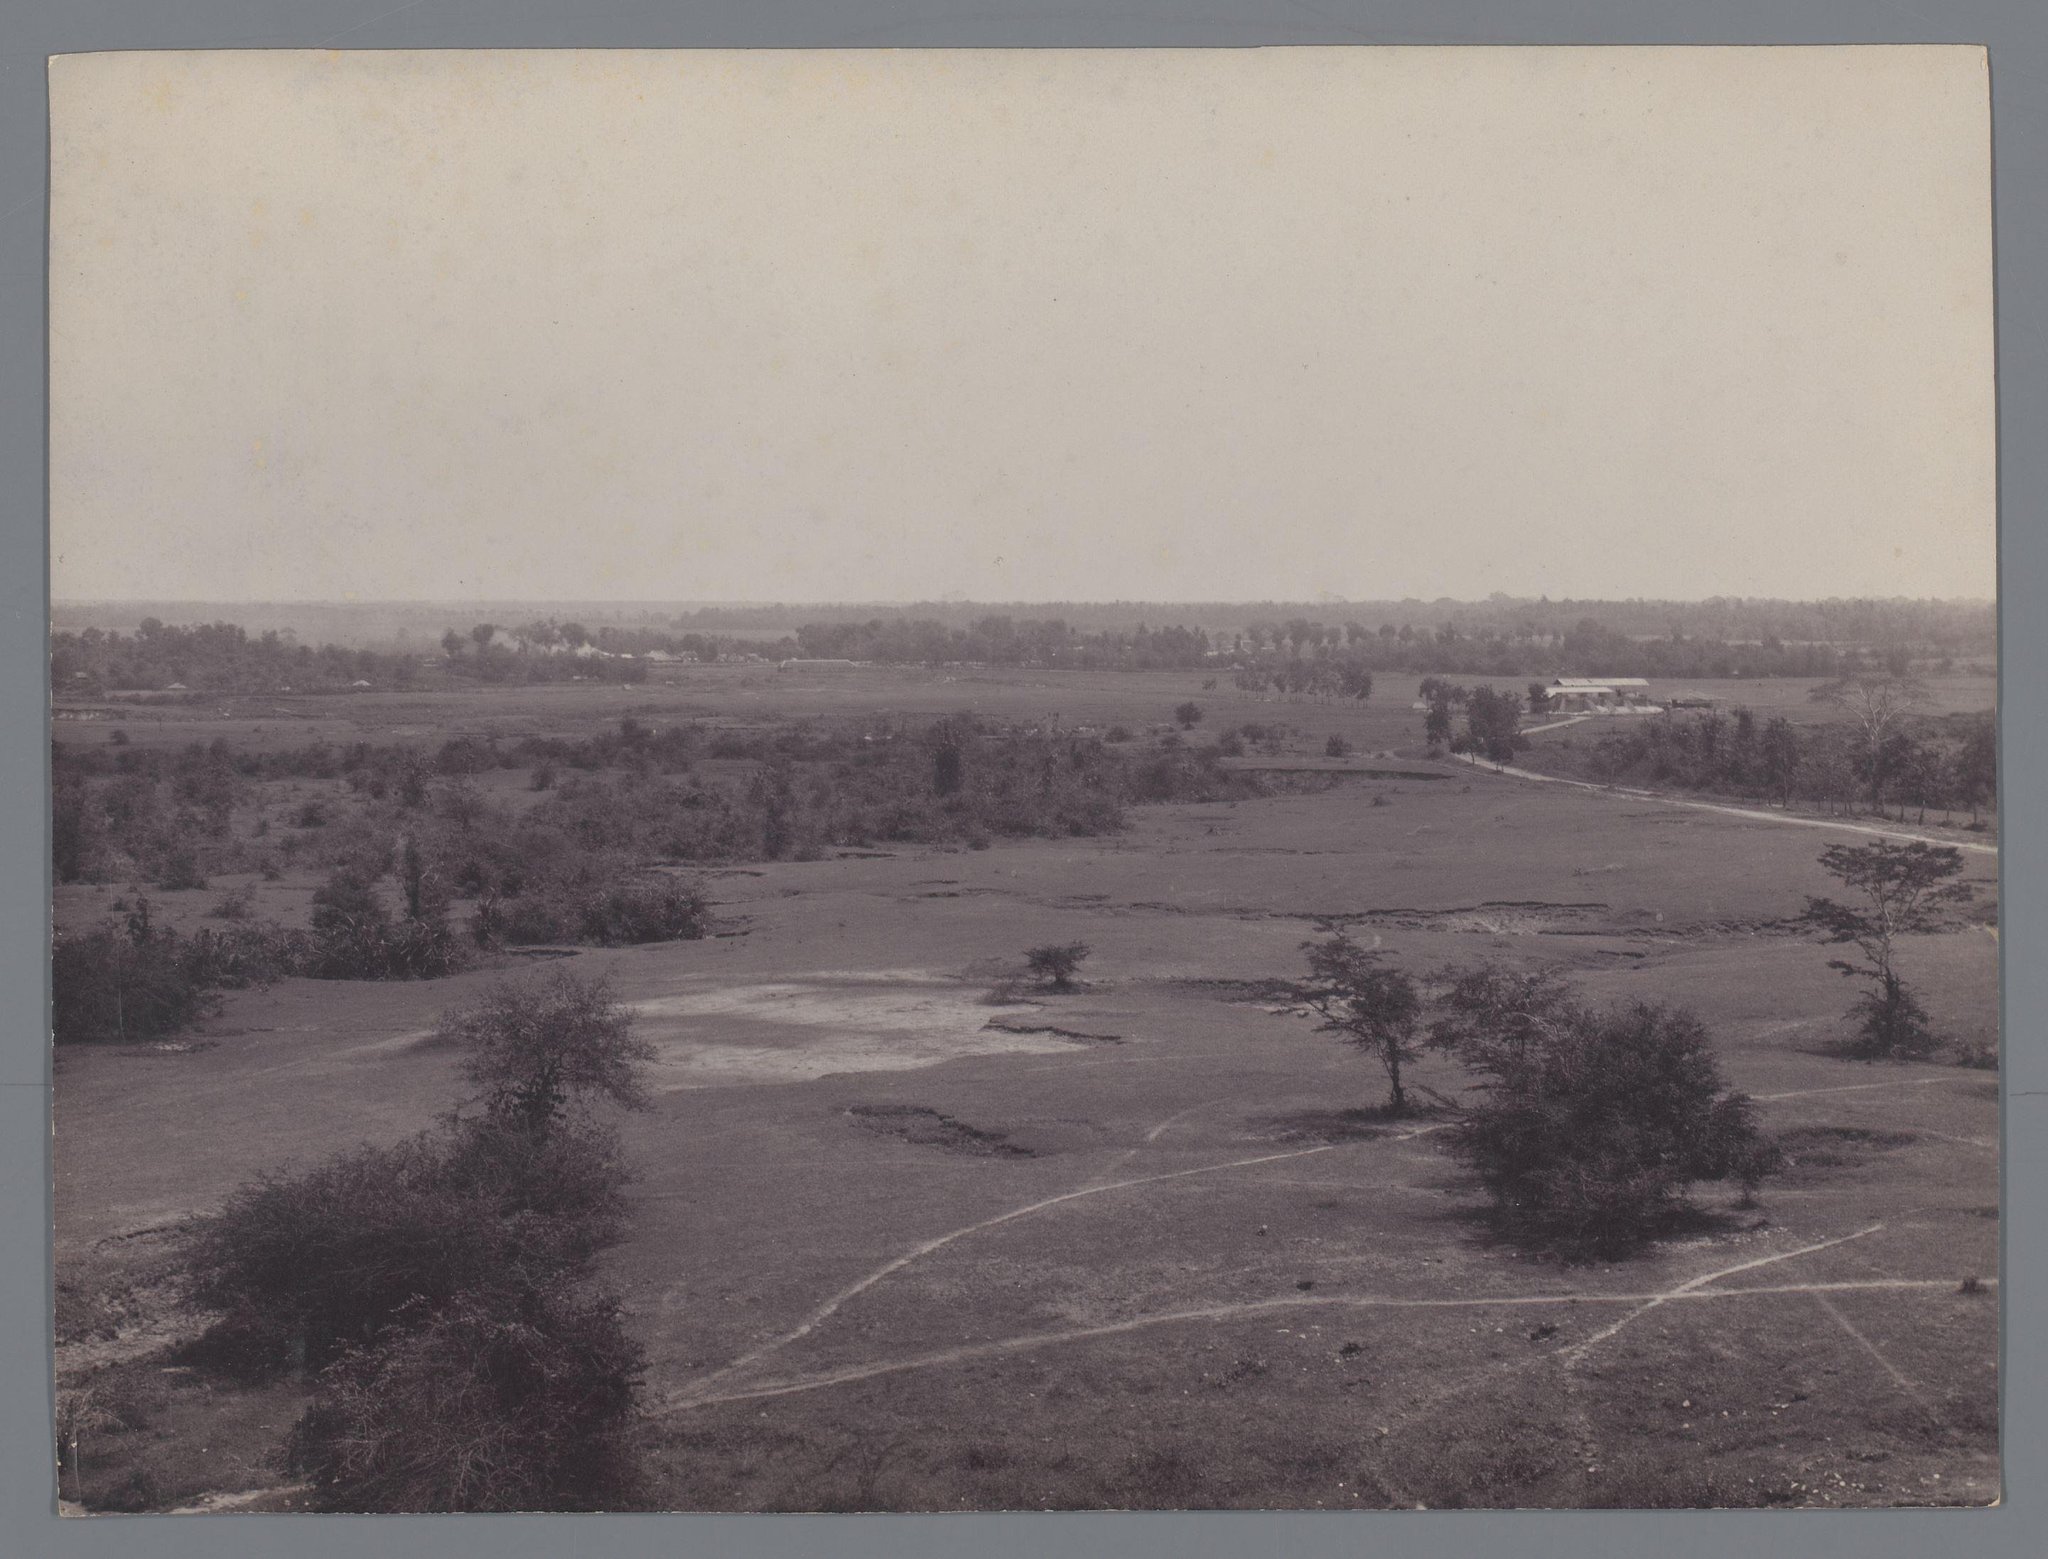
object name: photograph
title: Landschap in Nederlands-Indië [?]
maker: Anonymous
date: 1900-1915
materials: paper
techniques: albumen print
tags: dutch east indies, the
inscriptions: number: ‘no 26.’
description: Vlak landschap in Nederlands-Indië, met een grasvlakte en bomen en een huis in de verte.